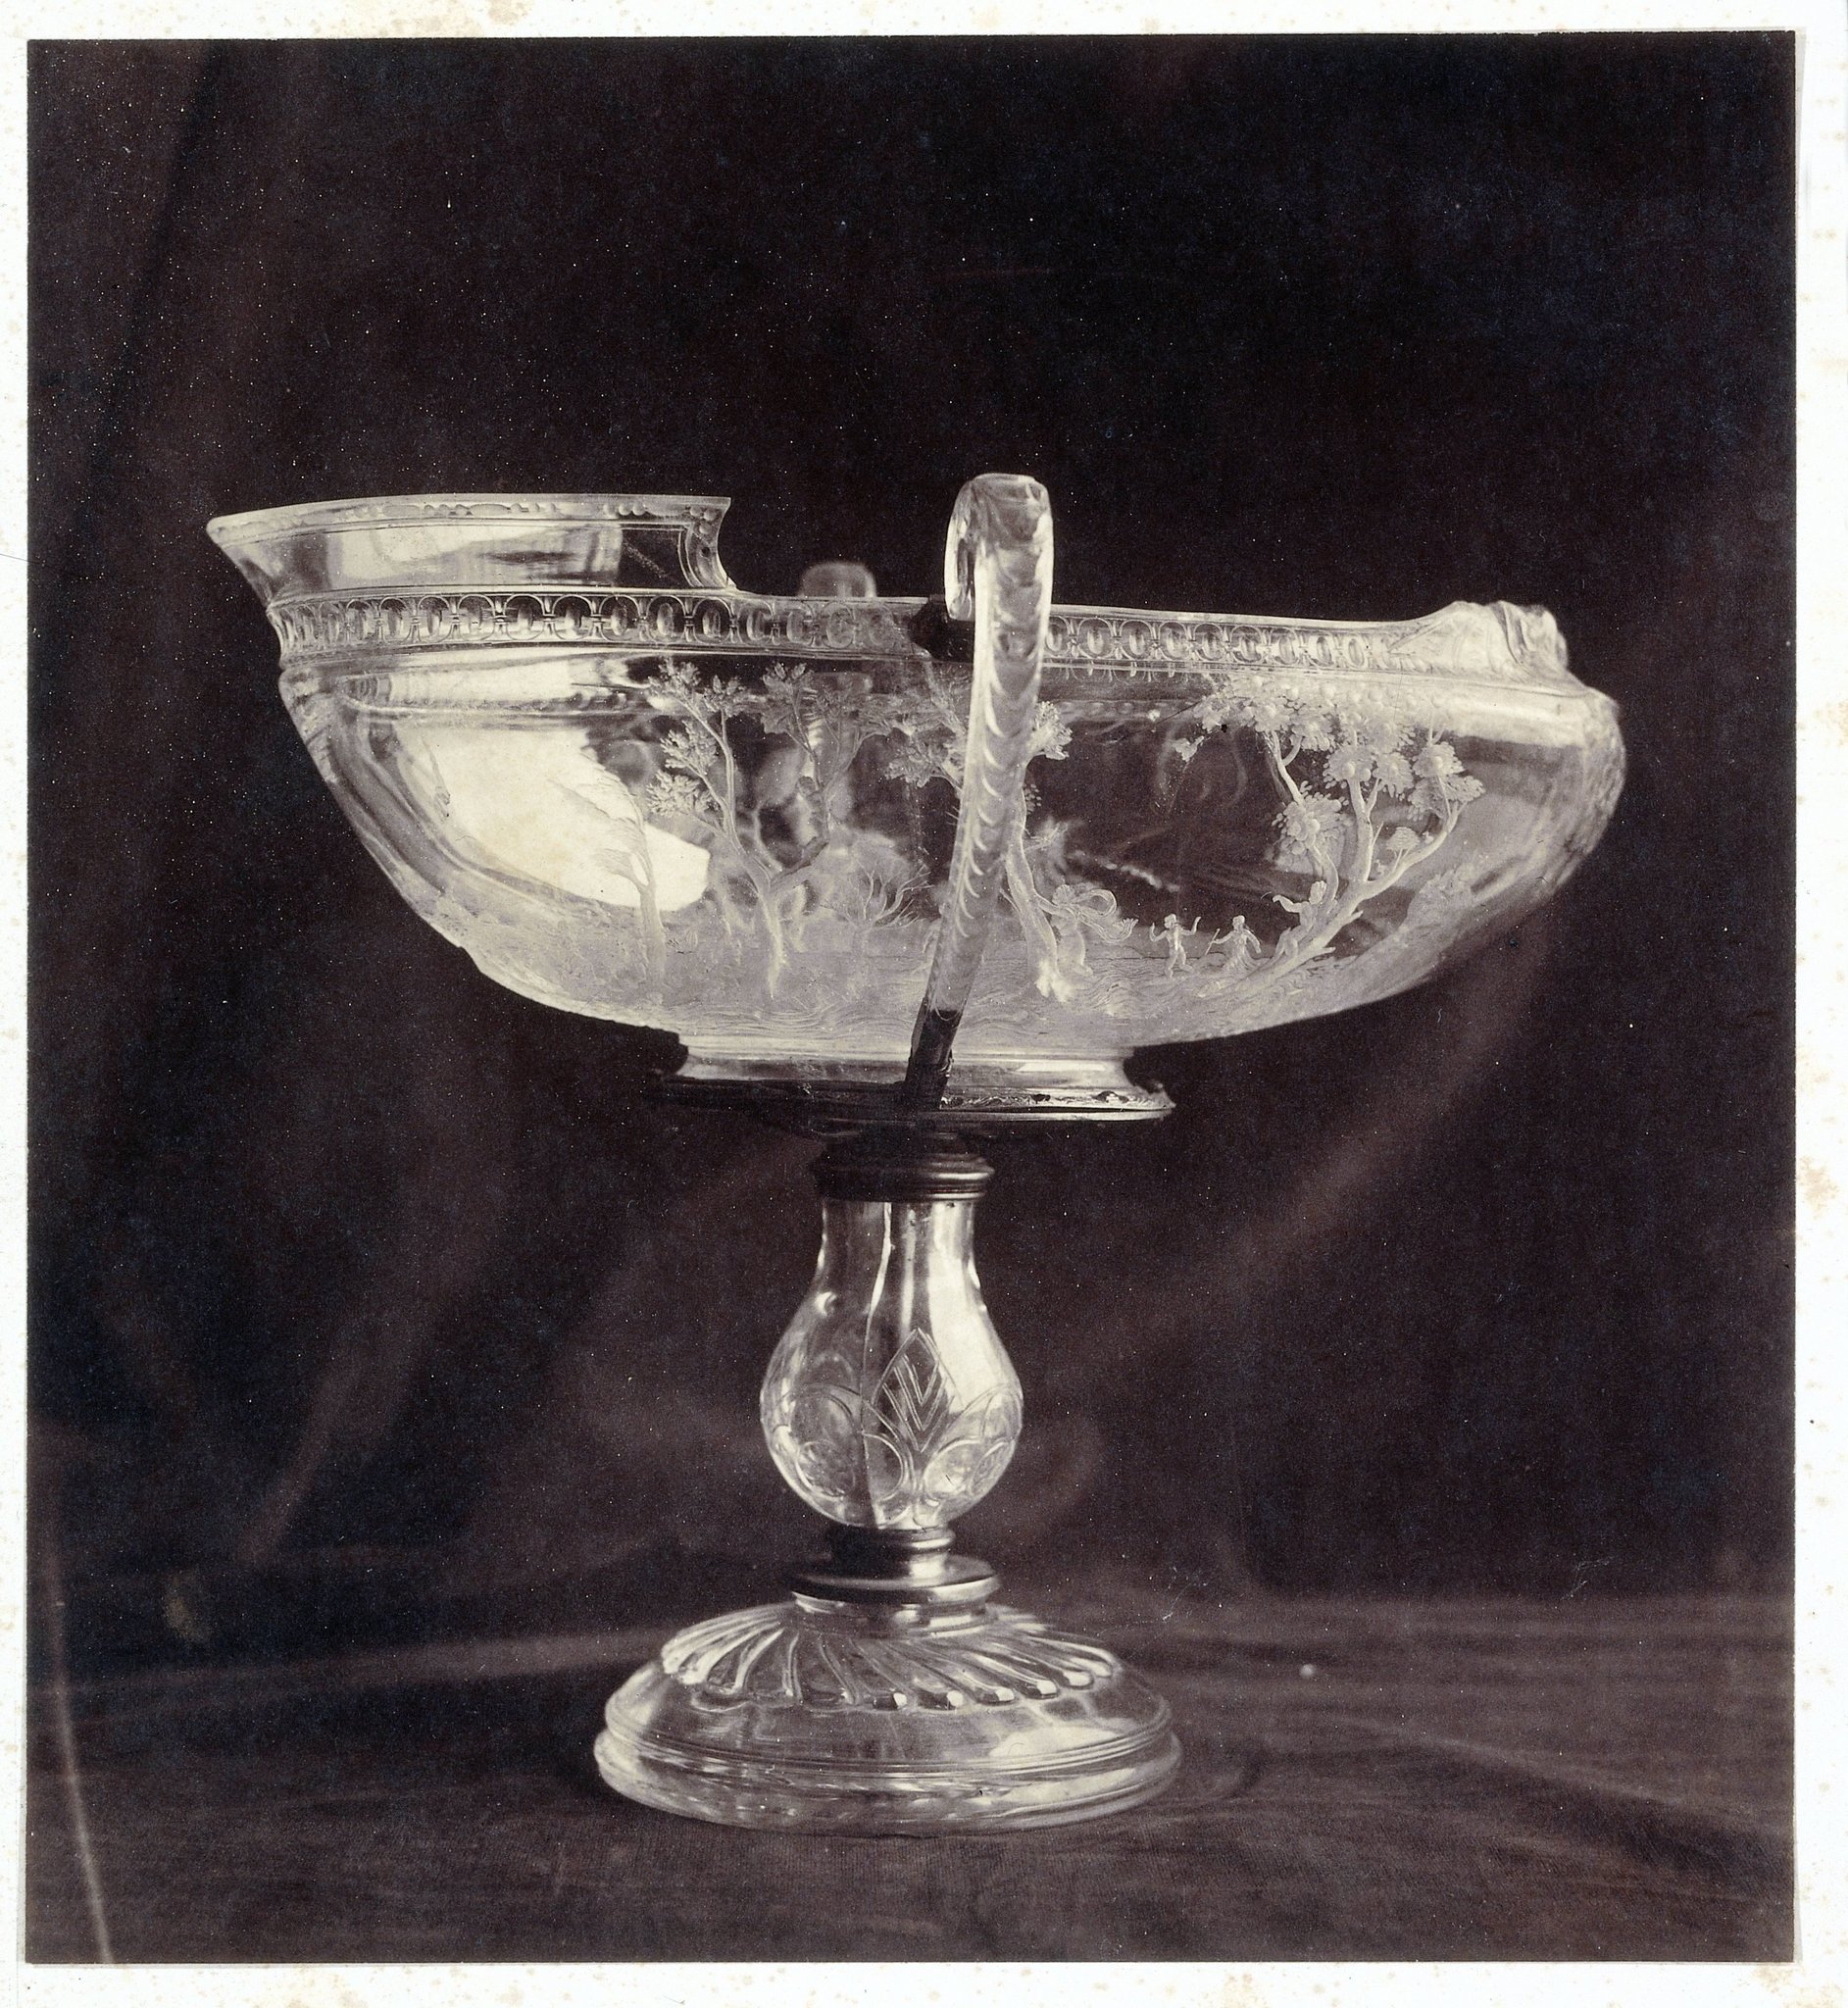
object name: photomechanical print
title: Kristallen gegraveerde schaal op voet, uit het Louvre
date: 1866-1890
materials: paper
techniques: woodburytype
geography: louvre museum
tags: container of glass: bottle, jar, vase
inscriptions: inscription: ‘Photographed by C. Thurston Thompson.’